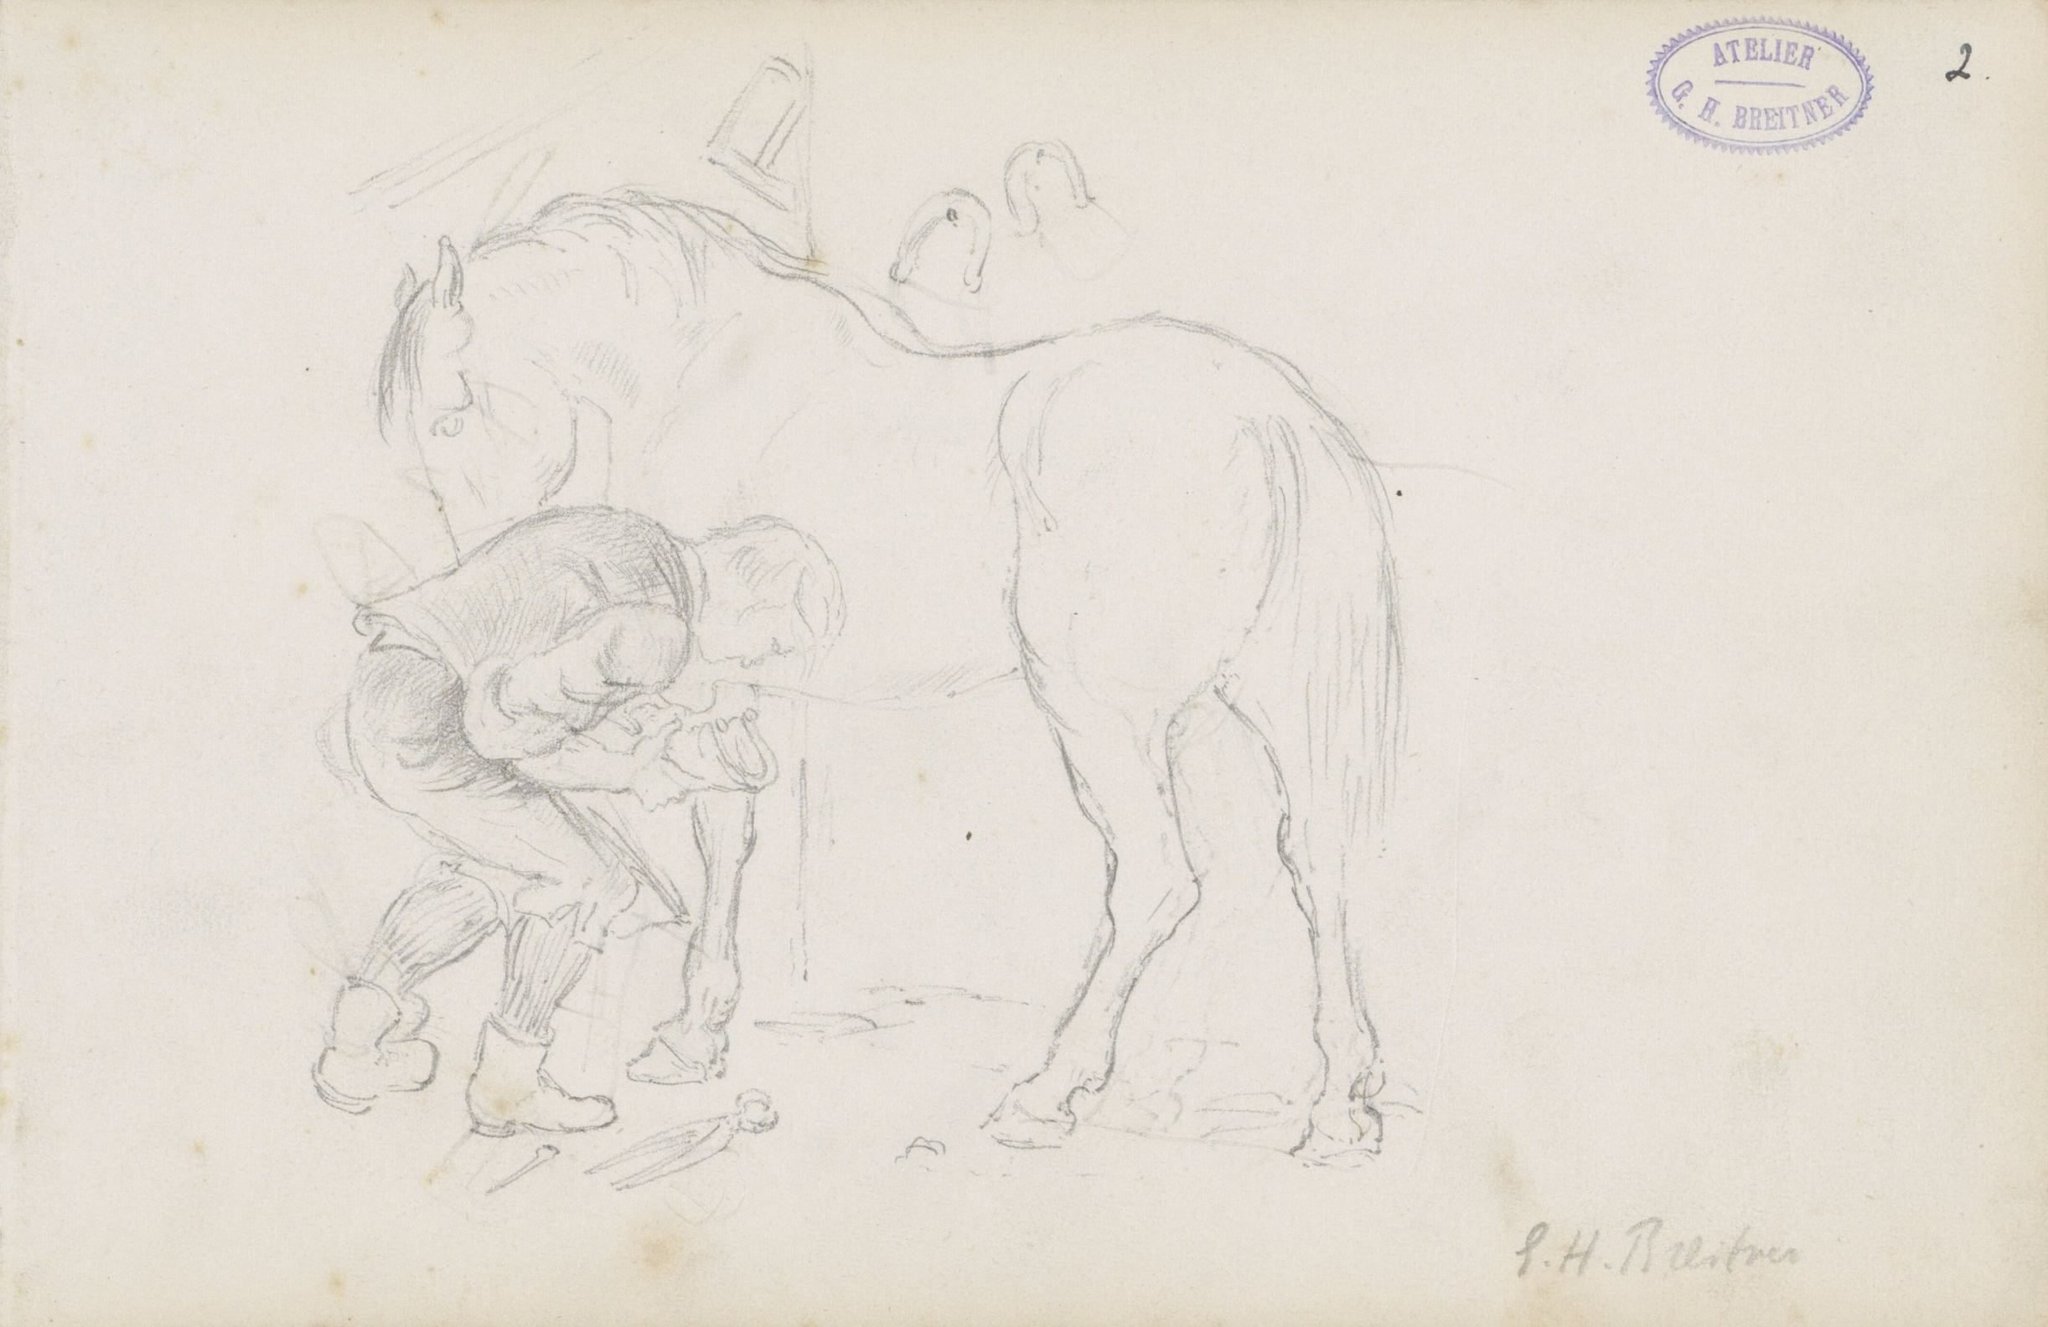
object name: drawing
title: Hoefsmid beslaat een paard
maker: george hendrik breitner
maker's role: draughtsman, painter, print maker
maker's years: 1857-1923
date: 1874-1876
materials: paper, pencil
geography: rotterdam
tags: farrier, shoeing-smith, horse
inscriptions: signature: ‘G.H. Breitner’, collector's mark: Lugt 2228, workshop stamp: Lugt 291d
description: Deze tekening heeft oorspronkelijk als blad 2 deel uitgemaakt van een schetsboek. Zie voor dit schetsboek het gerelateerd object.